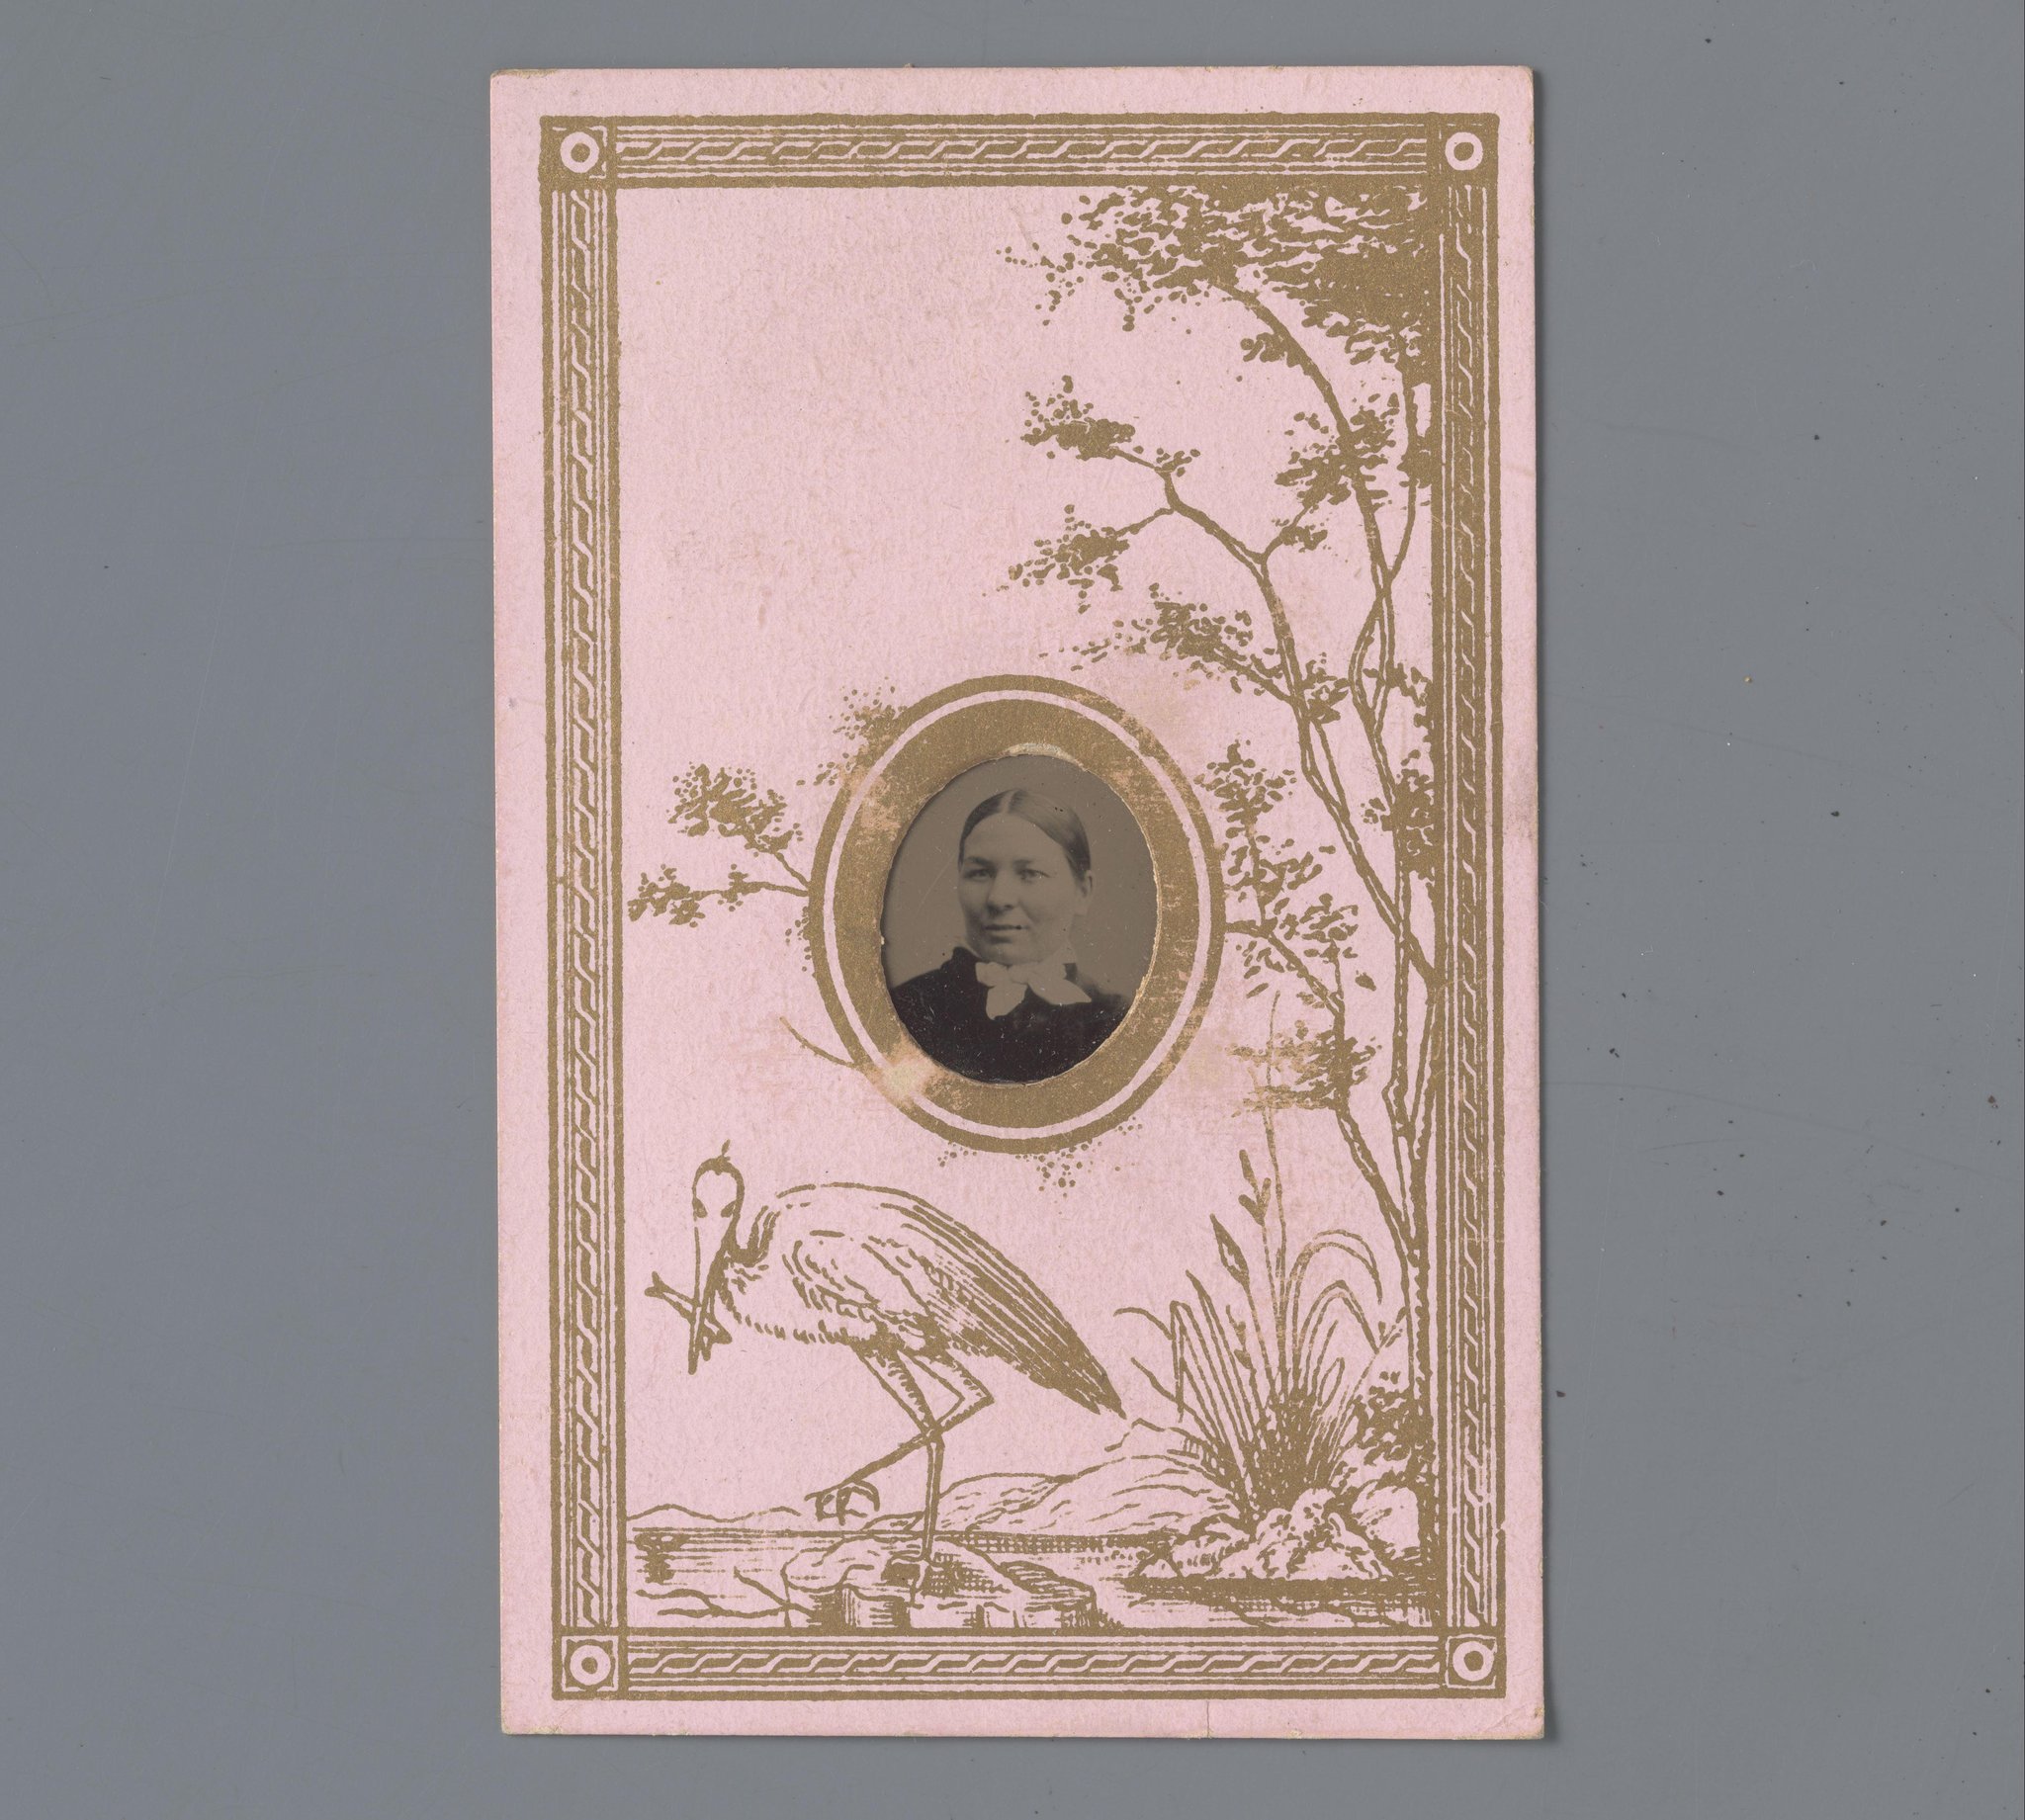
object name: photograph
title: Portret van een onbekende vrouw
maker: r.w. gibbs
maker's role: fotograaf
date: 1855-1900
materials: cardboard, iron, paper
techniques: ferrotyping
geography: middlesbrough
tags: historical persons - bb - woman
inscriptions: inscription: ‘R.W. Gibbs/ Photographer/ Middlesbrough’